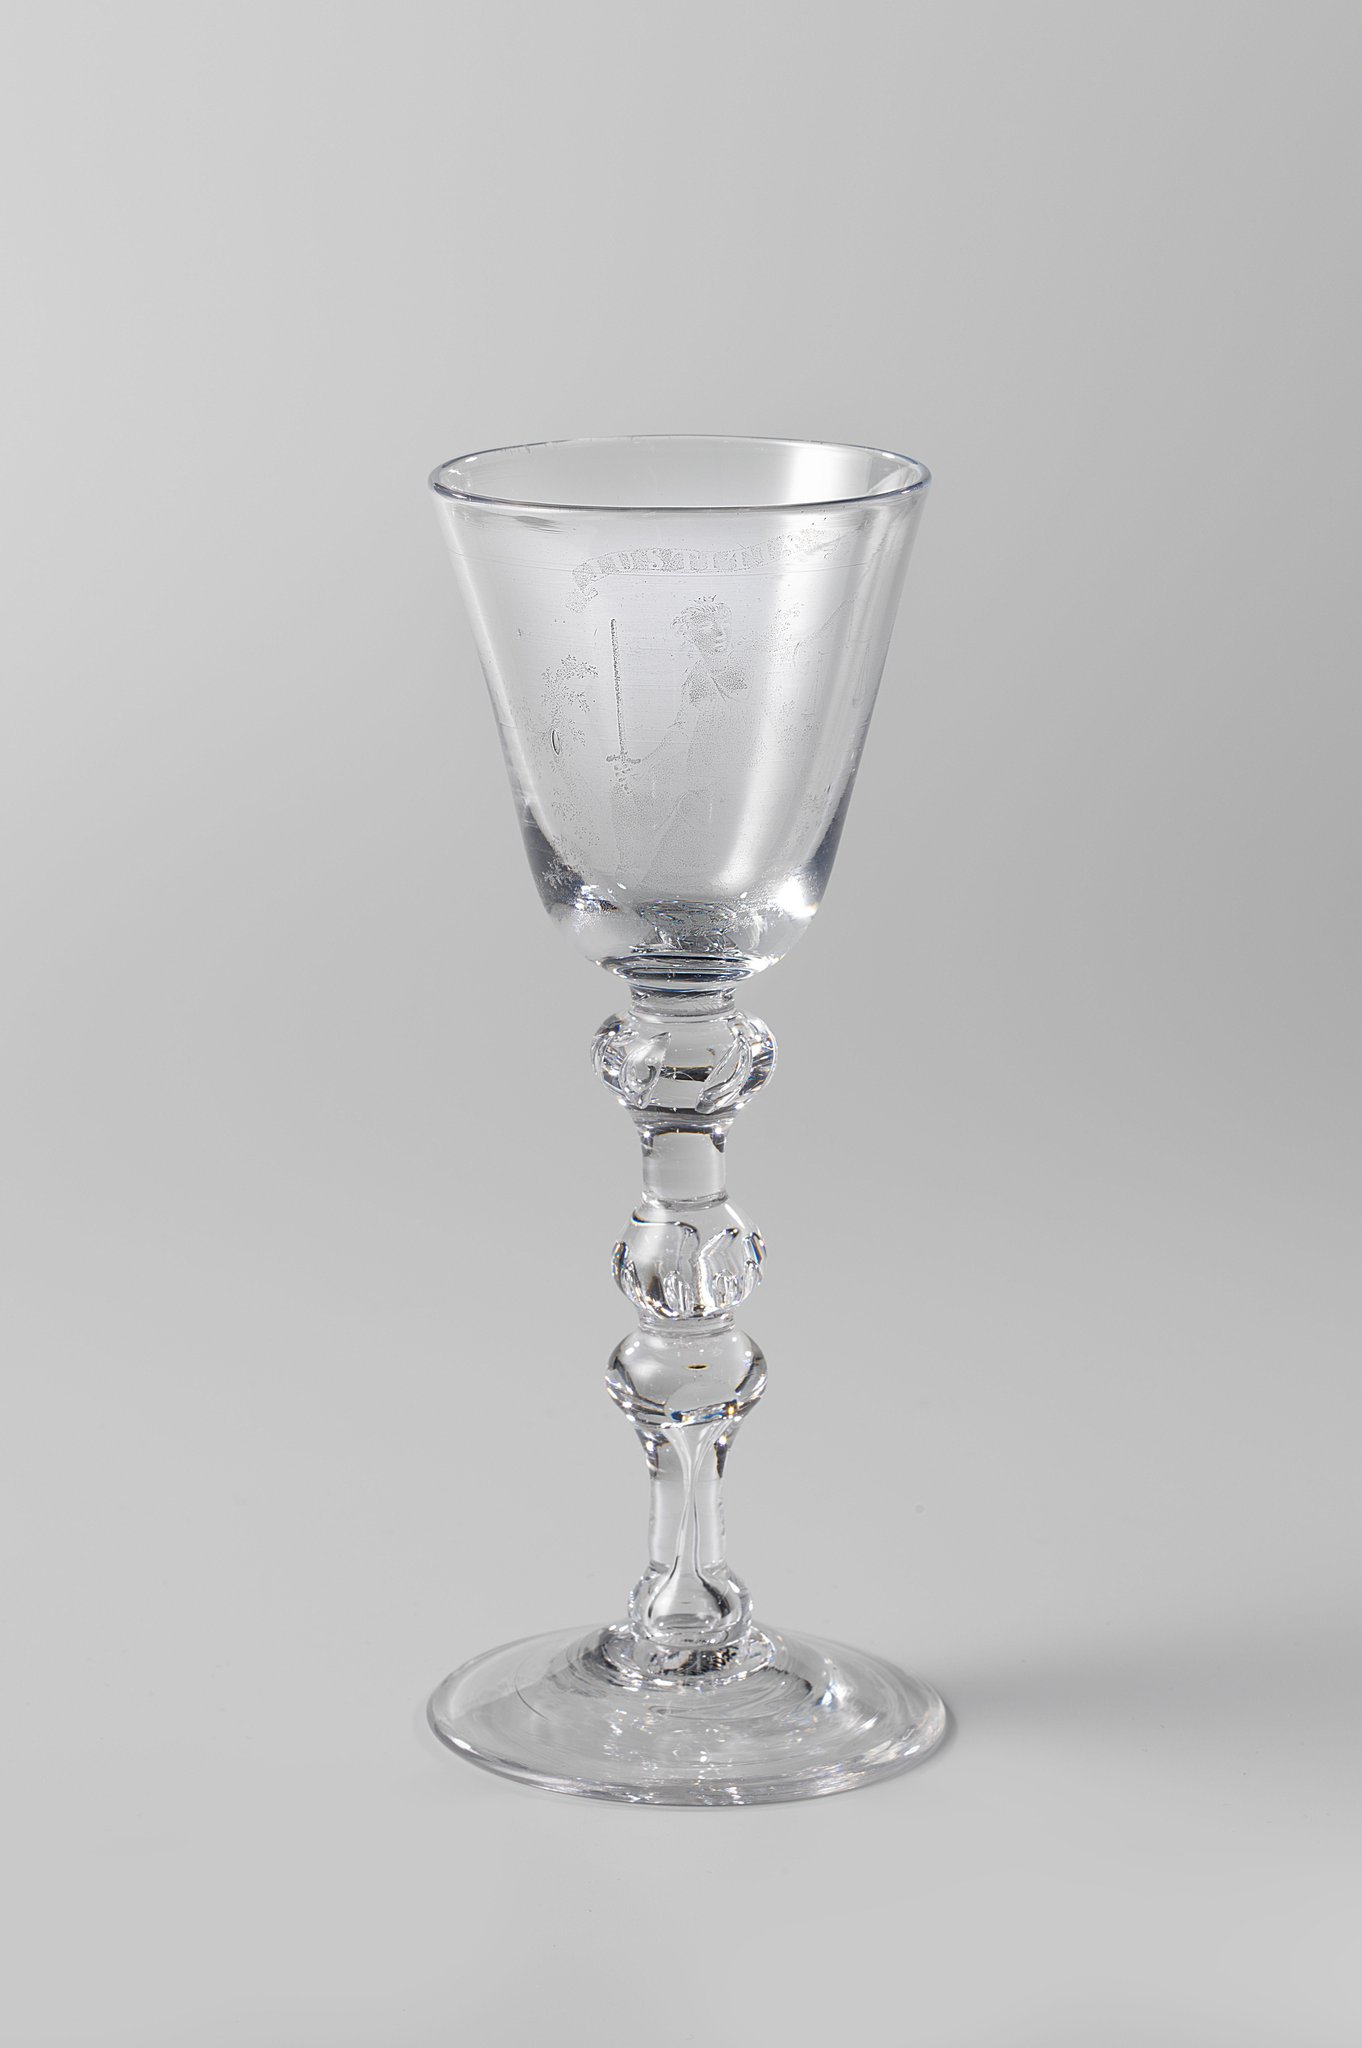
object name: goblet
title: Kelkglas met een voorstelling van IUSTITIA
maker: Anonymous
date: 1760-1780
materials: glass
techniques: glassblowing, engraving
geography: northern netherlands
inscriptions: inscription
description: Conische voet. Balustervormige stam met een traanvormige luchtbel, twee knopen met een krans luchtbellen. Conische, aan de onderzijde afgeronde kelk. Op de kelk, tegen een achtergrond van bomen, Iustitia, gepersonifieerd door een tronende vrouw met zwaard en weegschaal. Boven haar een banderolle met de tekst: IUSTITIA.